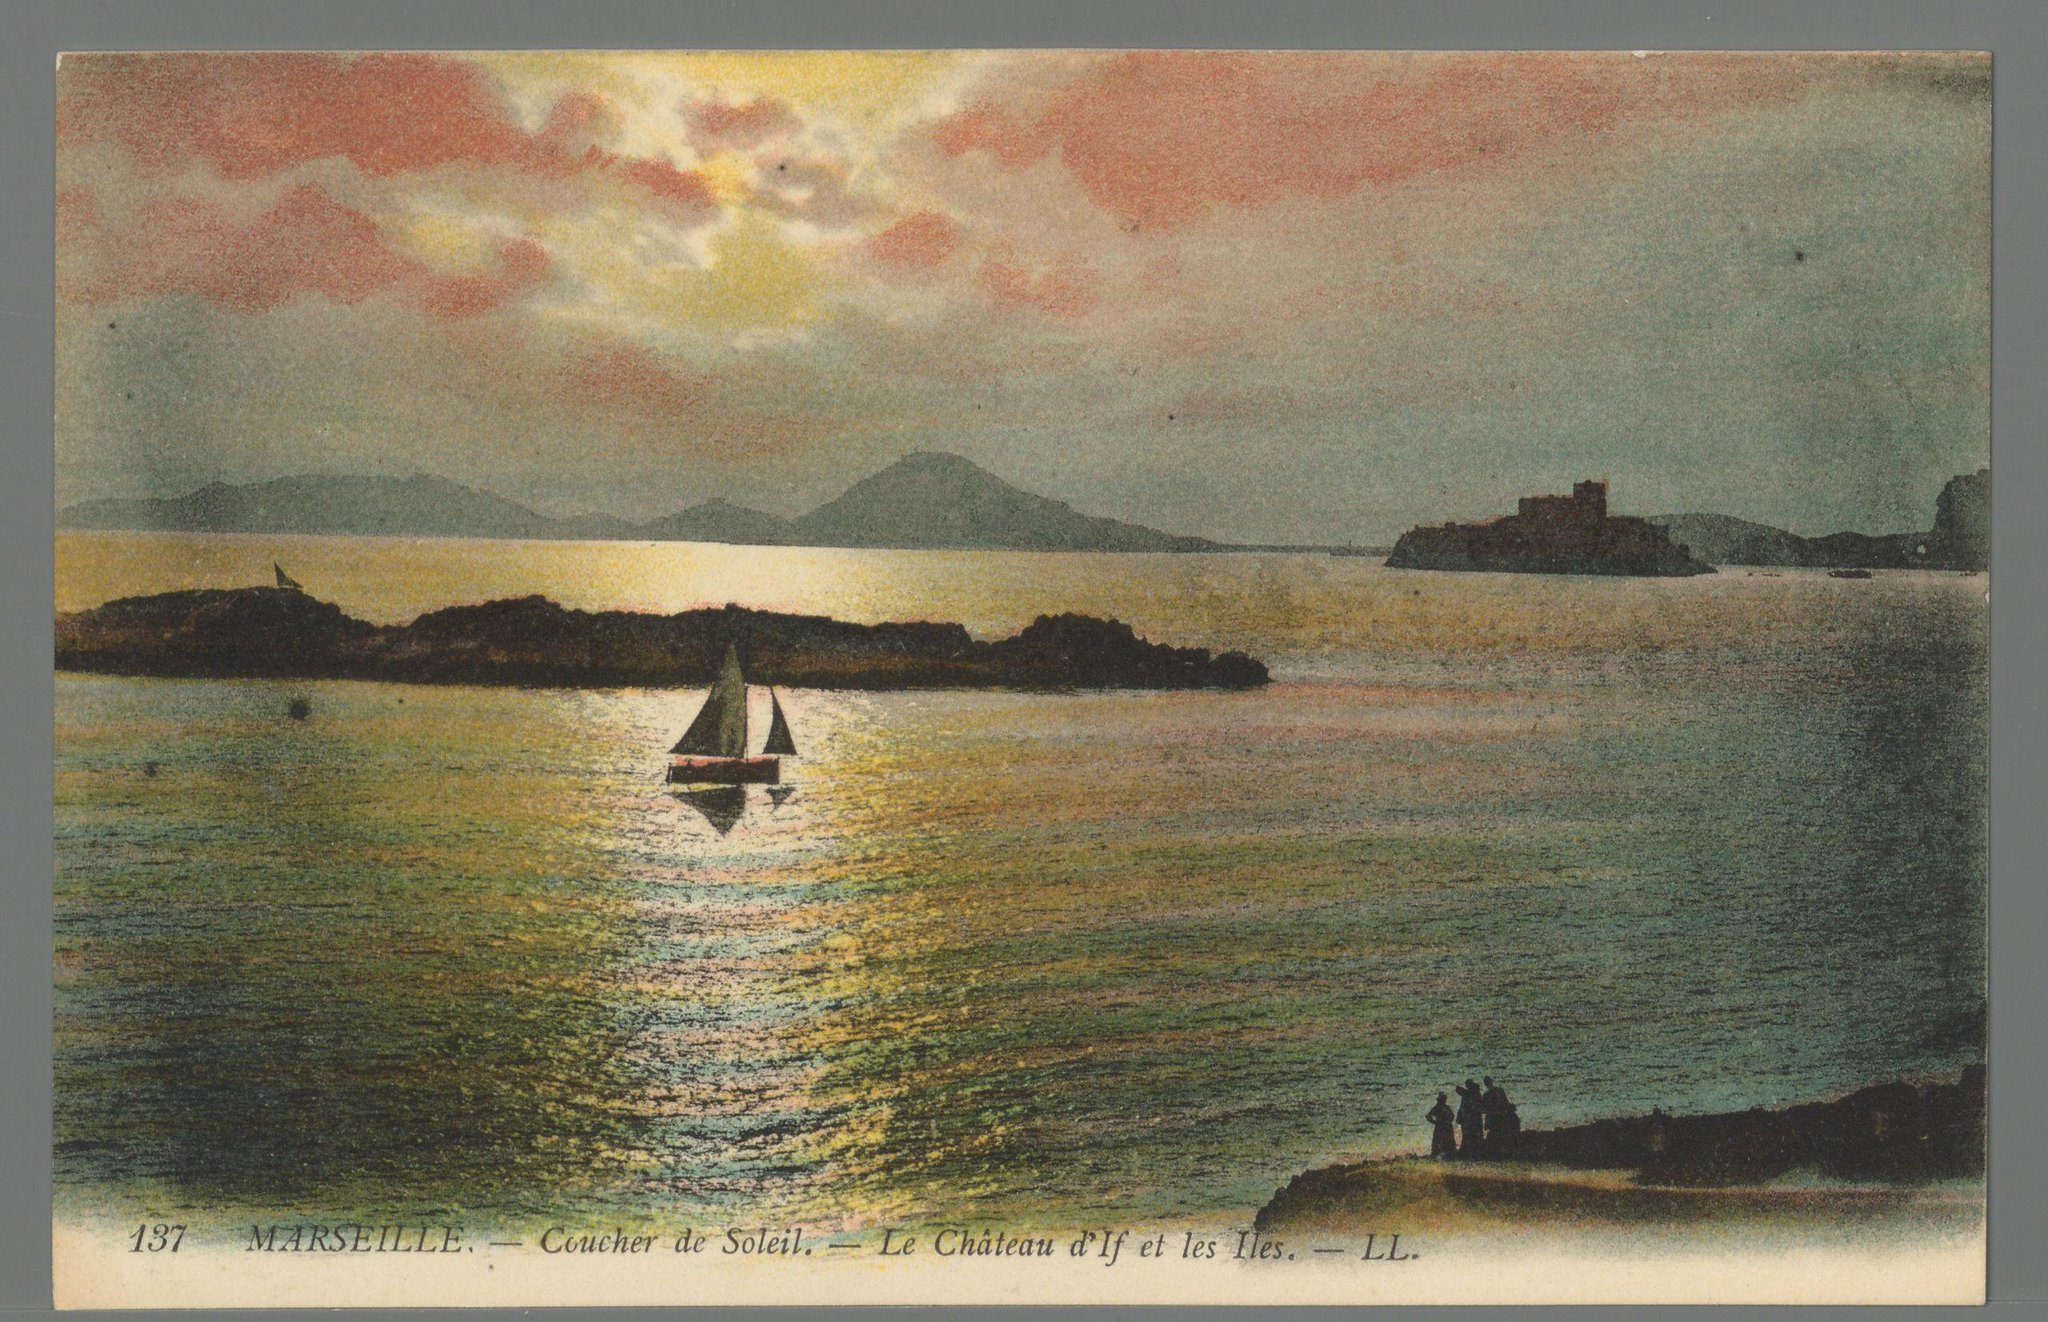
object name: photomechanical print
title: Marseille. Coucher de Soleil. Le Château d'If et les Iles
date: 1903-1920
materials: cardboard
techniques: photograph, lithograph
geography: paris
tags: sailing-ship, sailing-boat, castle, sea (seascape), sunset